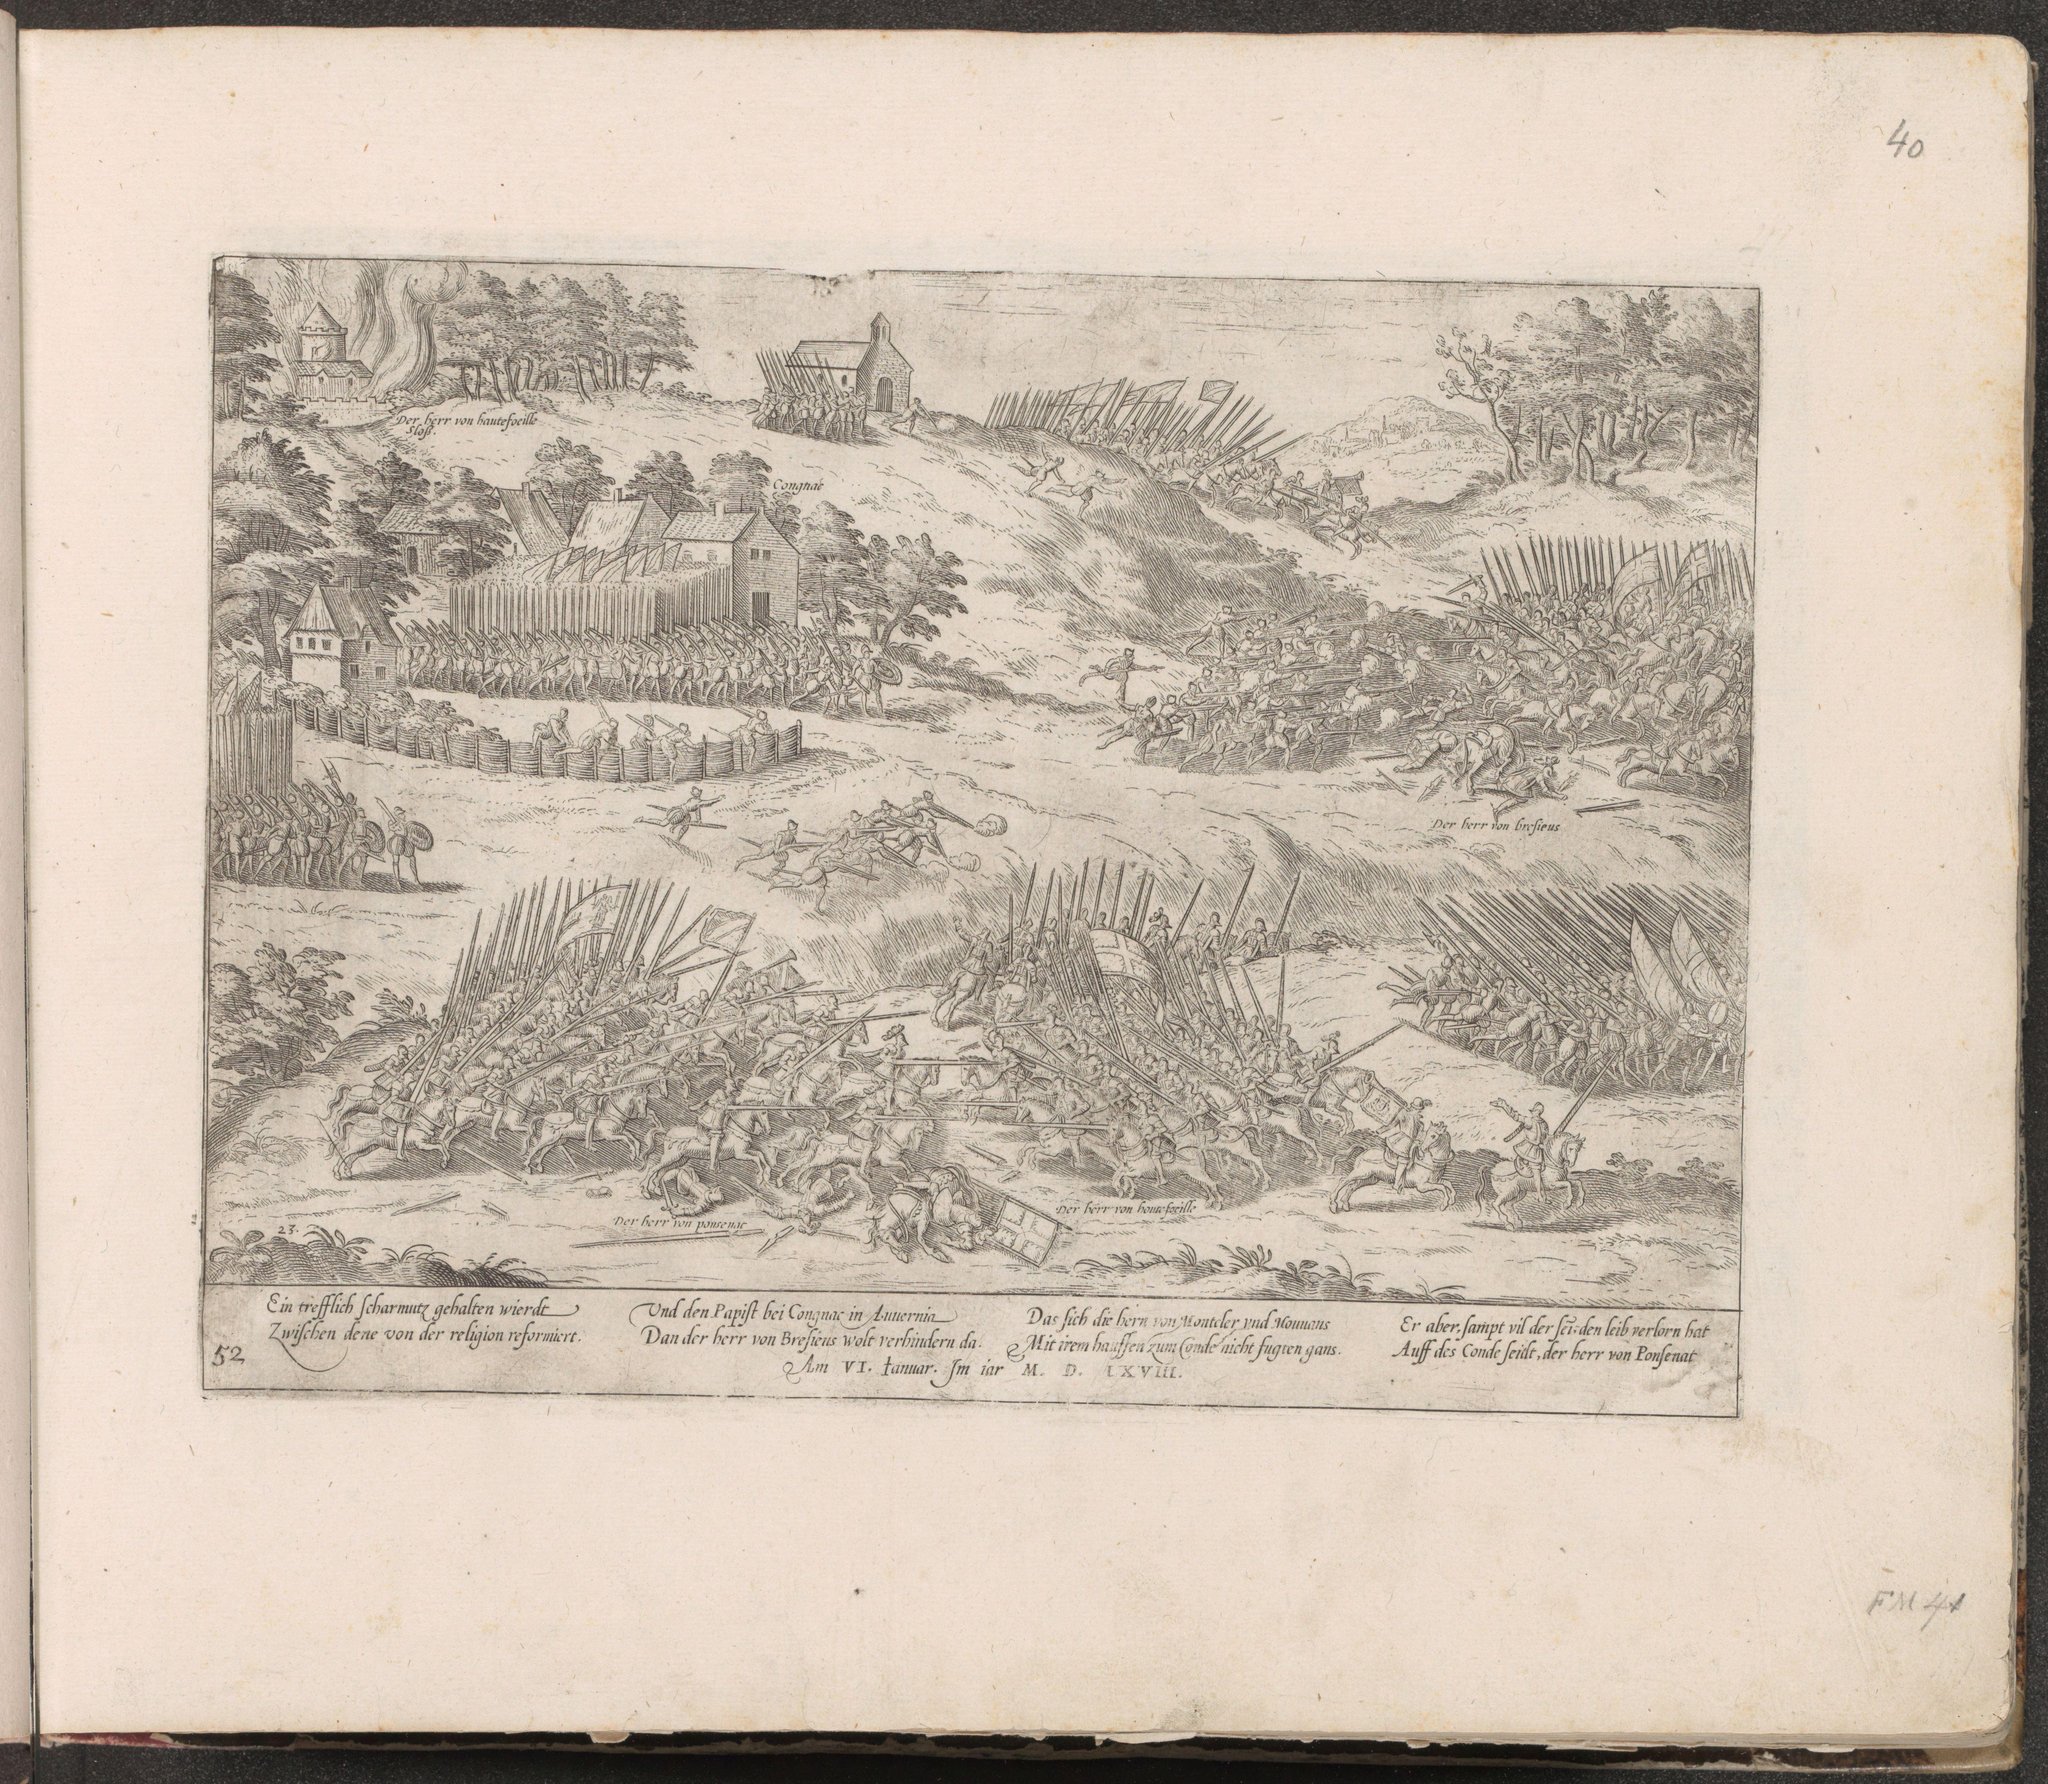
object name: print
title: Serie 3: Franse Godsdienstoorlogen, 1559-1573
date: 1568-1571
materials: paper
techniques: etching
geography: cologne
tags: battle (+ land forces)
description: Slag bij Cognac in de Auvergne, 6 januari 1568. Gezicht op het slagveld. Met onderschrift van 8 regels in het Duits. Linksonder genummerd: 52. De prent maakt deel uit van een album.